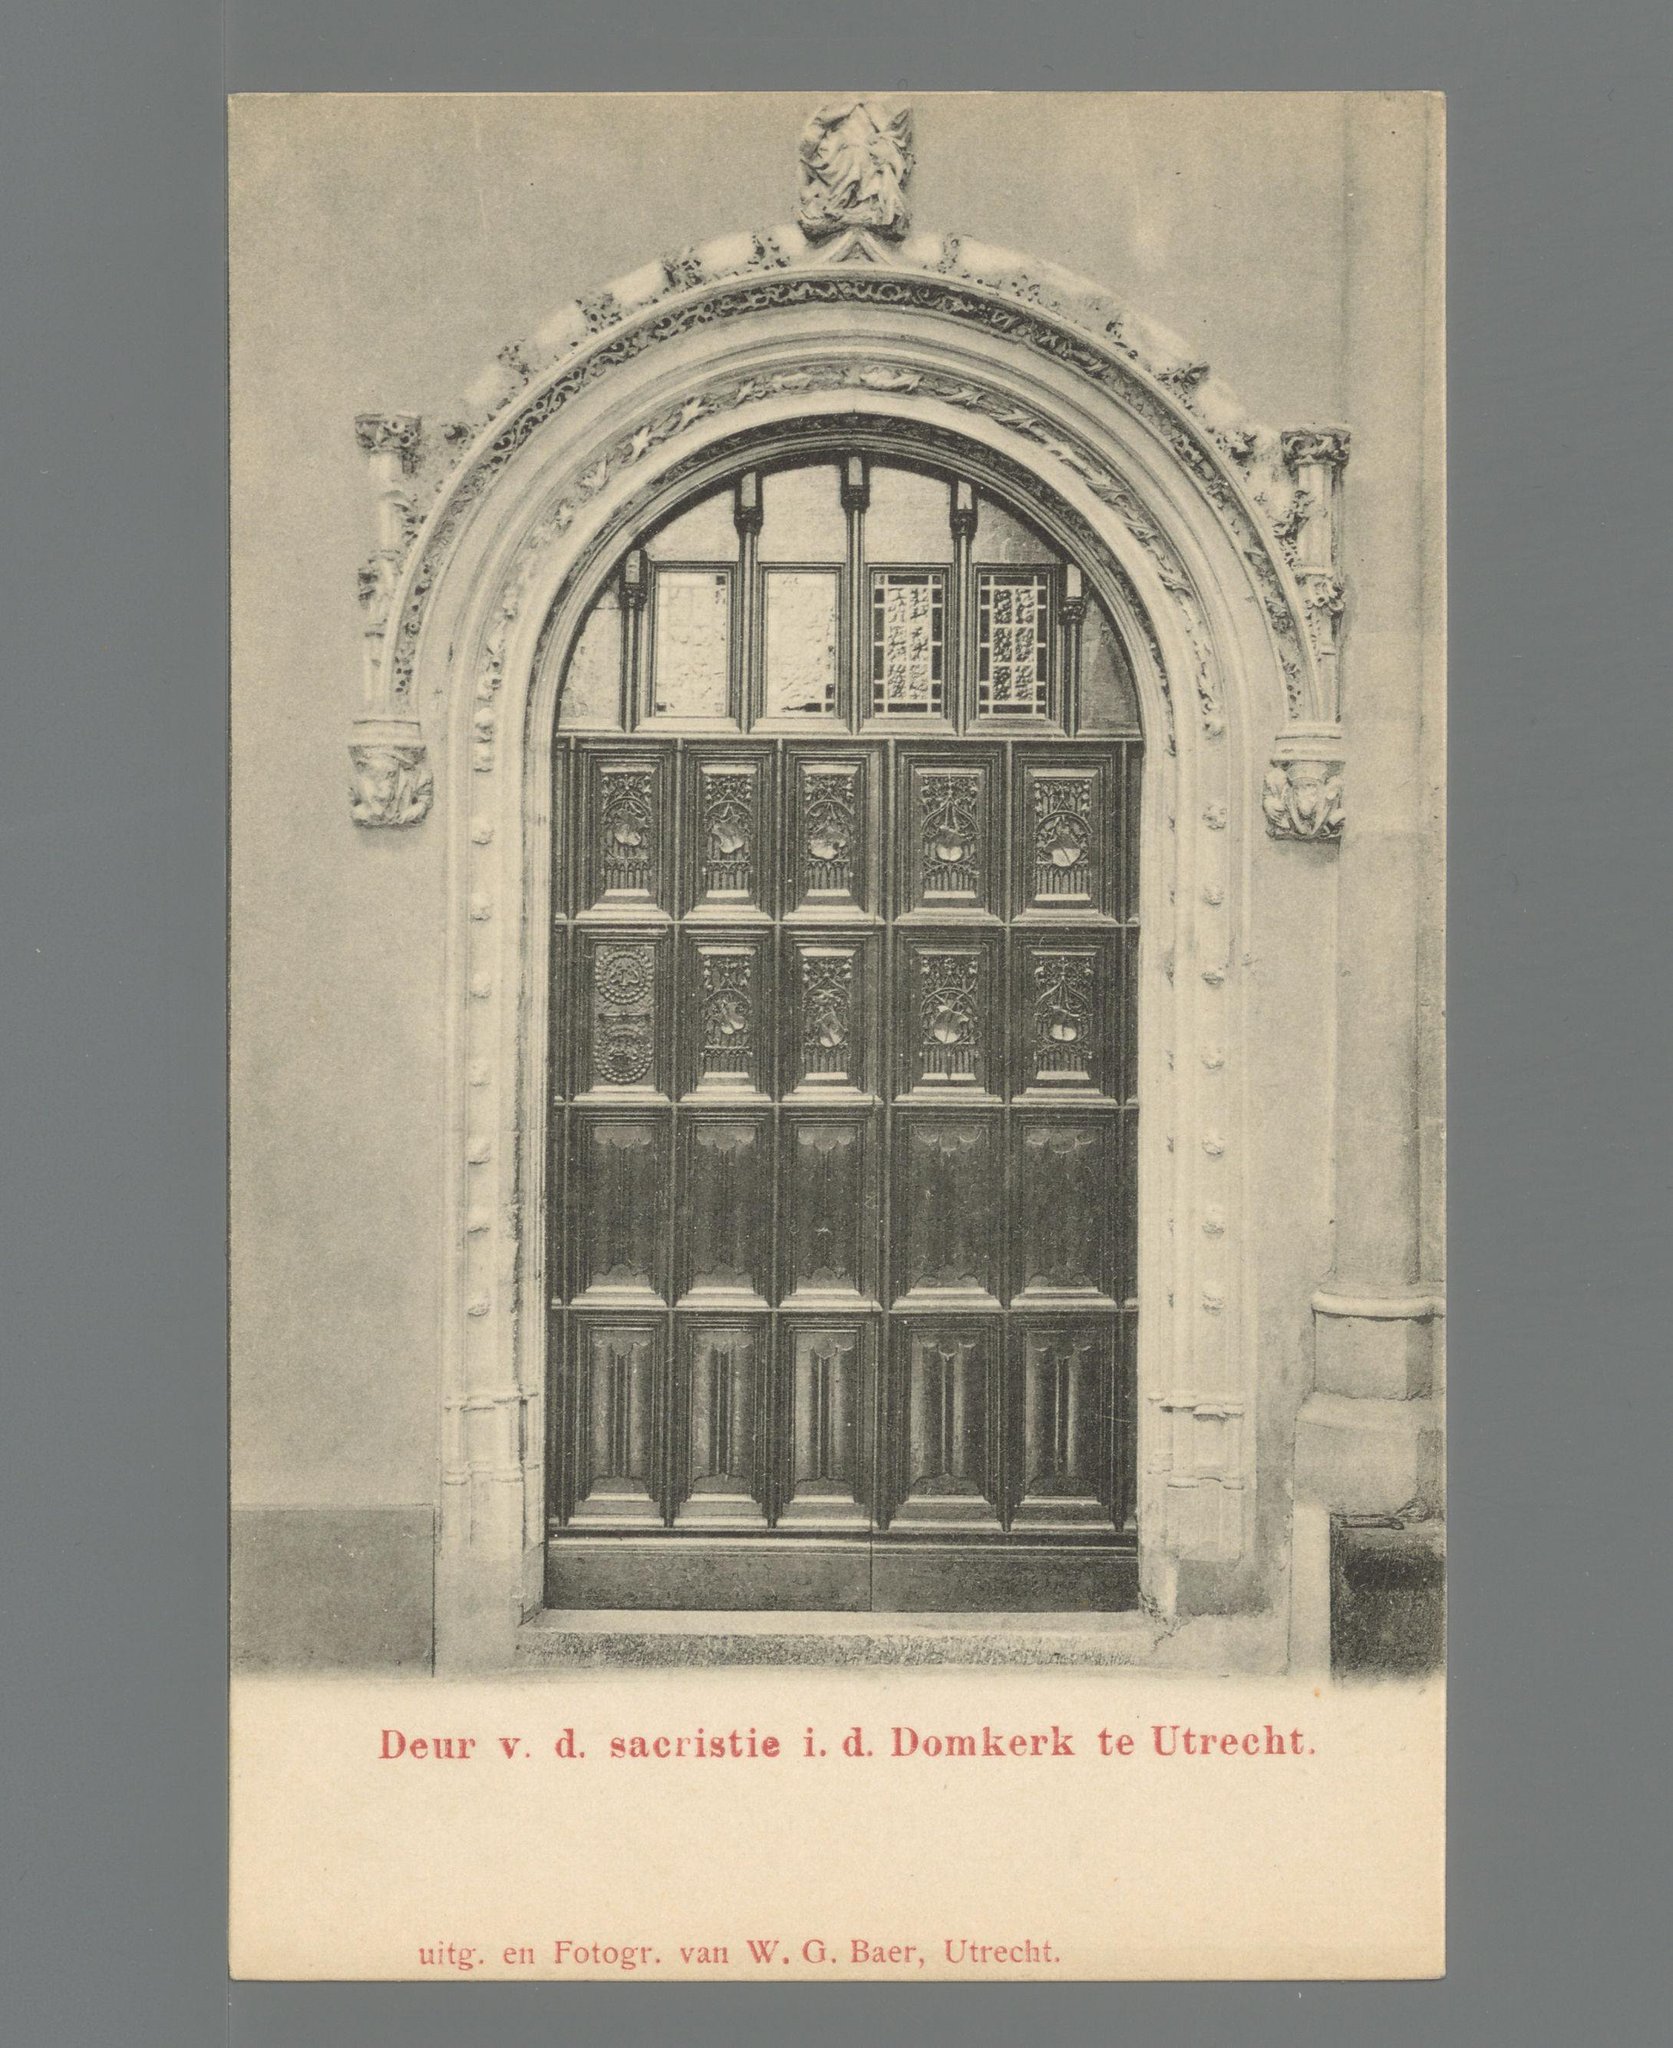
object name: ansichtkaart, prentbriefkaart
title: Deur v. d. sacristie i. d. Domkerk te Utrecht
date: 1897-1905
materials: cardboard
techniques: photograph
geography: utrecht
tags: gate, entrance, interior of church